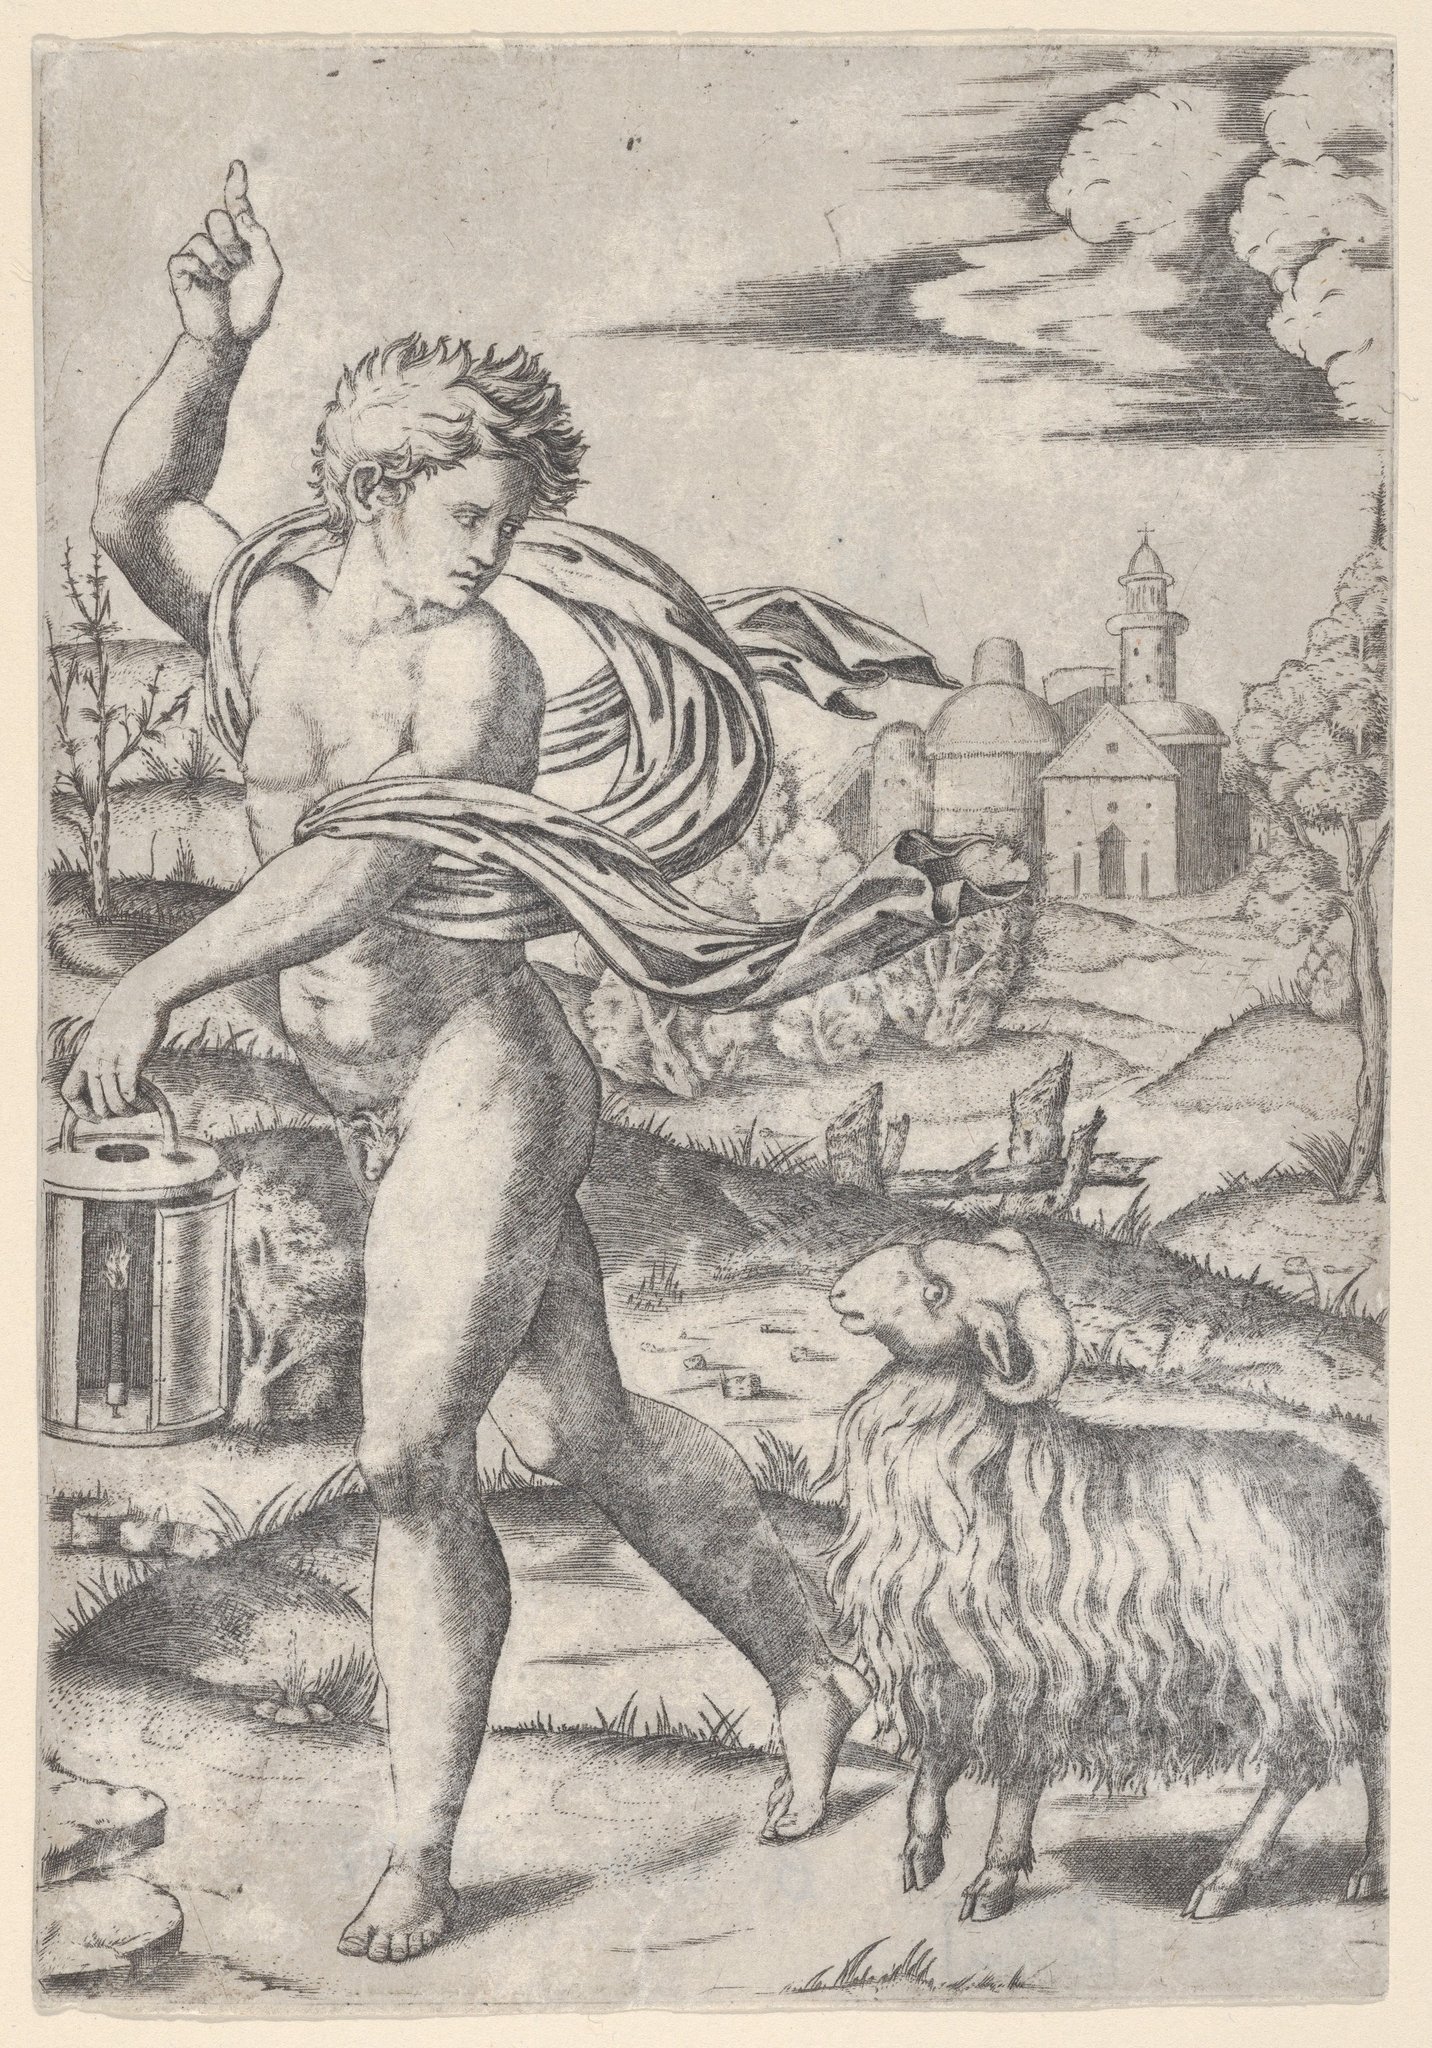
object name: print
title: A naked young man walking left, carrying a lantern and looking backwards over his shoulder at a ram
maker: marcantonio raimondi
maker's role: artist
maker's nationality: italian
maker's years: 1475-1534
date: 1510-1527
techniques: engraving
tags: male nudes,rams